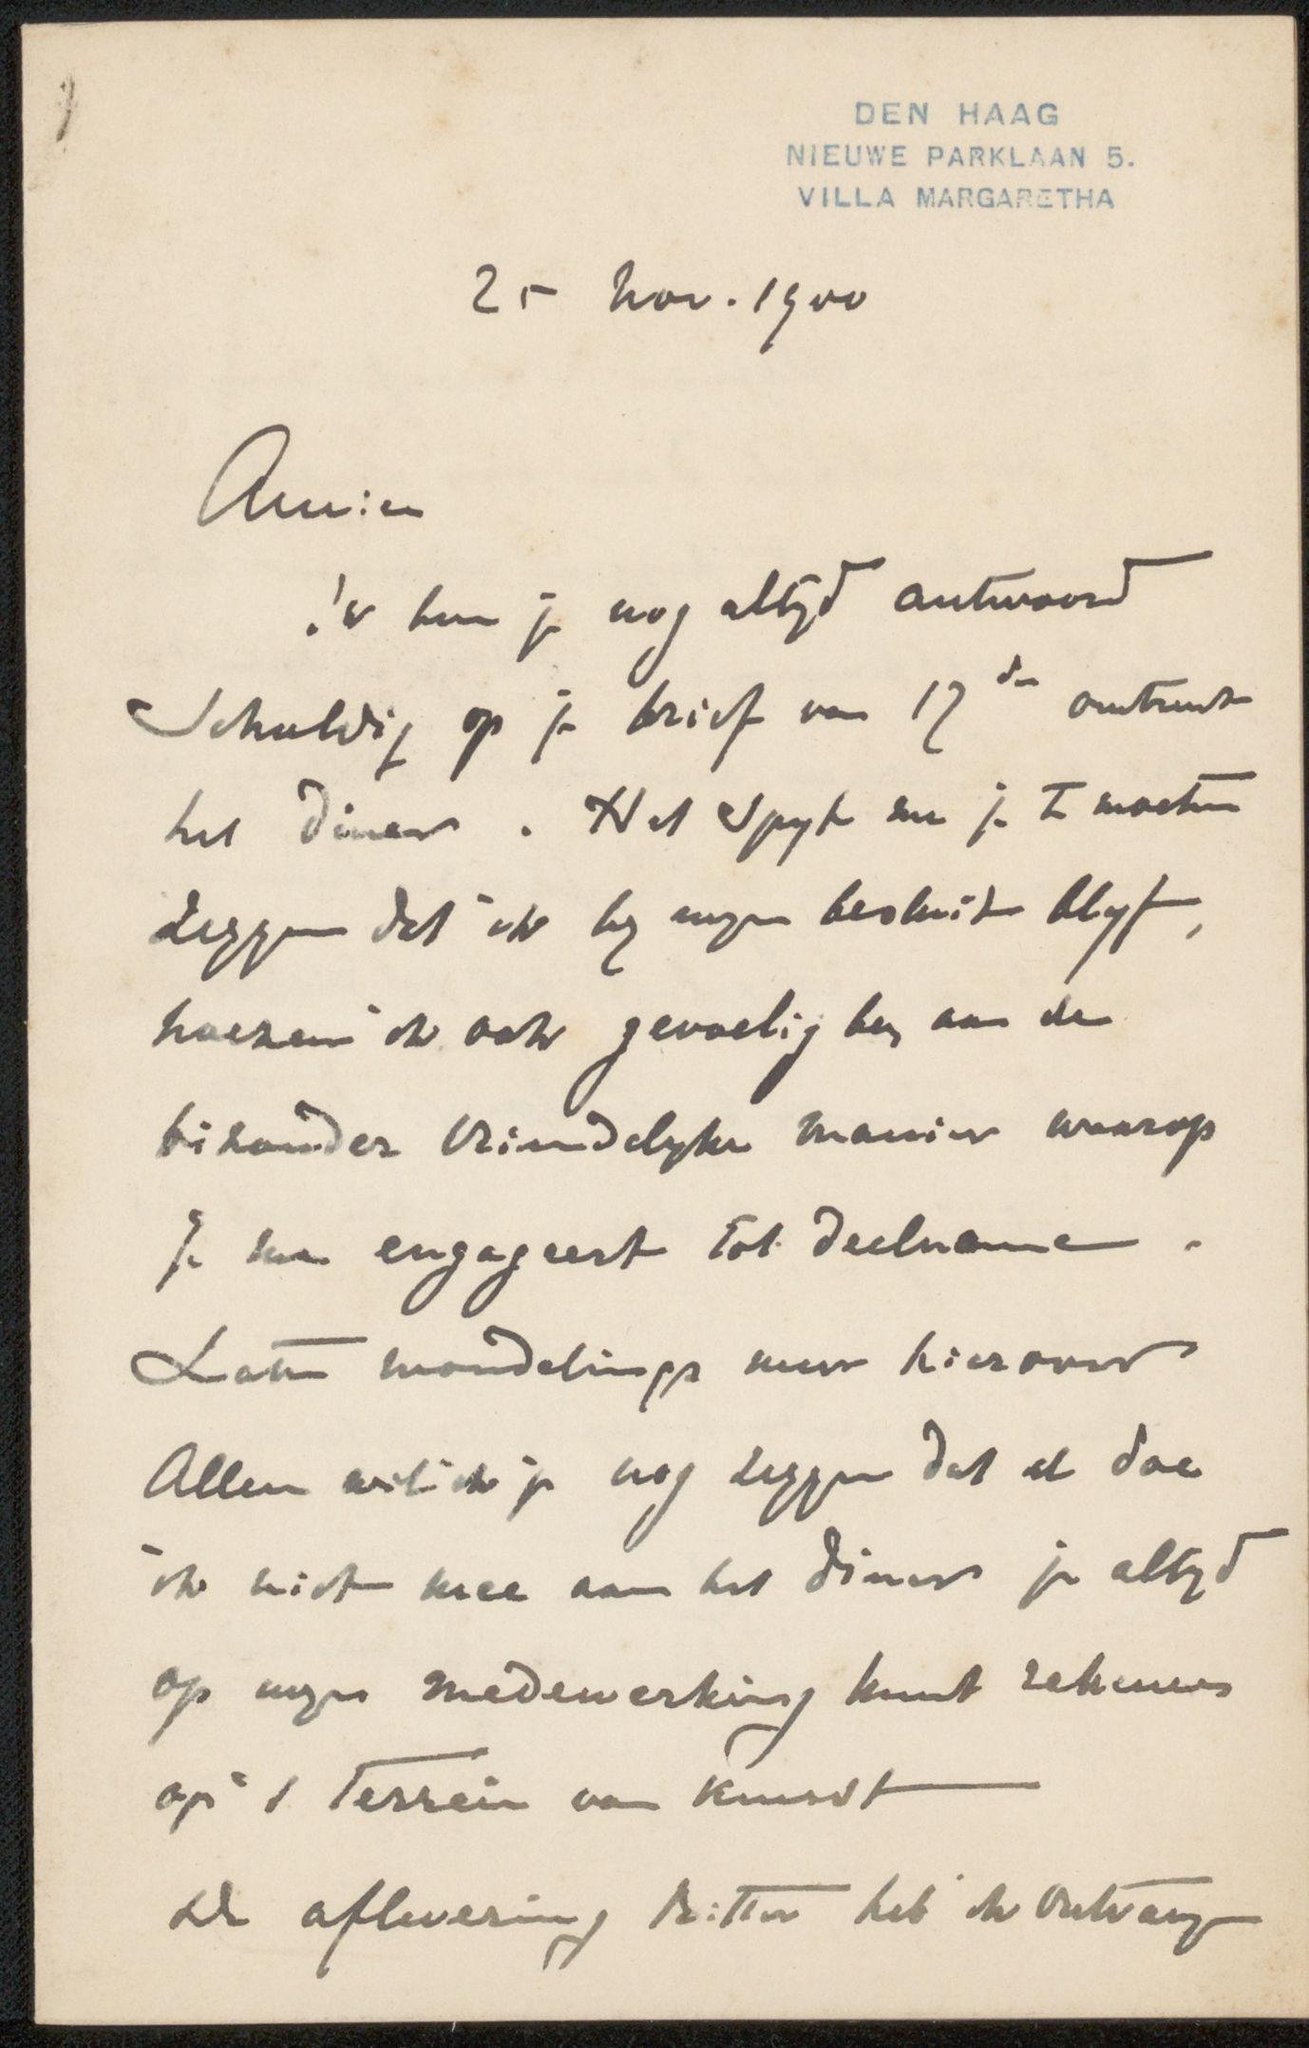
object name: letter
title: Brief aan Philip Zilcken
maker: carel nicolaas storm van s-gravesande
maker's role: draughtsman, print maker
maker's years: 1841-1924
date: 1900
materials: ink, paper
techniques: pen, writing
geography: the hague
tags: the hague, draughtsman, philip zilcken, drawing, the graphic arts, exhibition ~ art, vienna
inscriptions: watermark, collector's mark: ‘RPK’, address: ‘DEN HAAG/ NIEUWE PARKLAAN 5./ VILLA MARGARETHA’